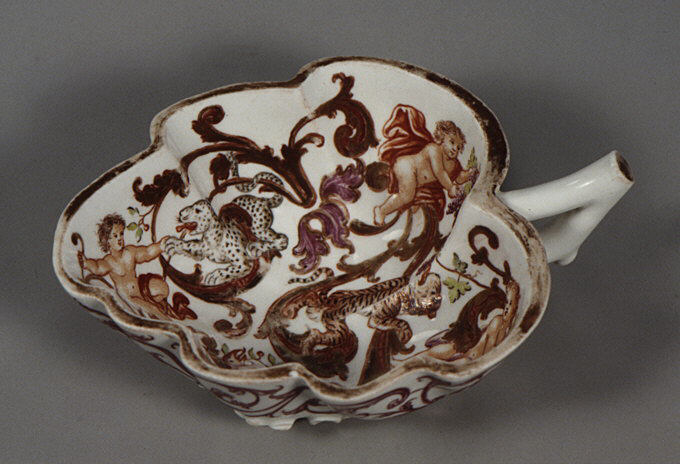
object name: dish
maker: vienna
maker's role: manufactory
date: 1725-1730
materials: hard paste porcelain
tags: putti,leopards,tigers